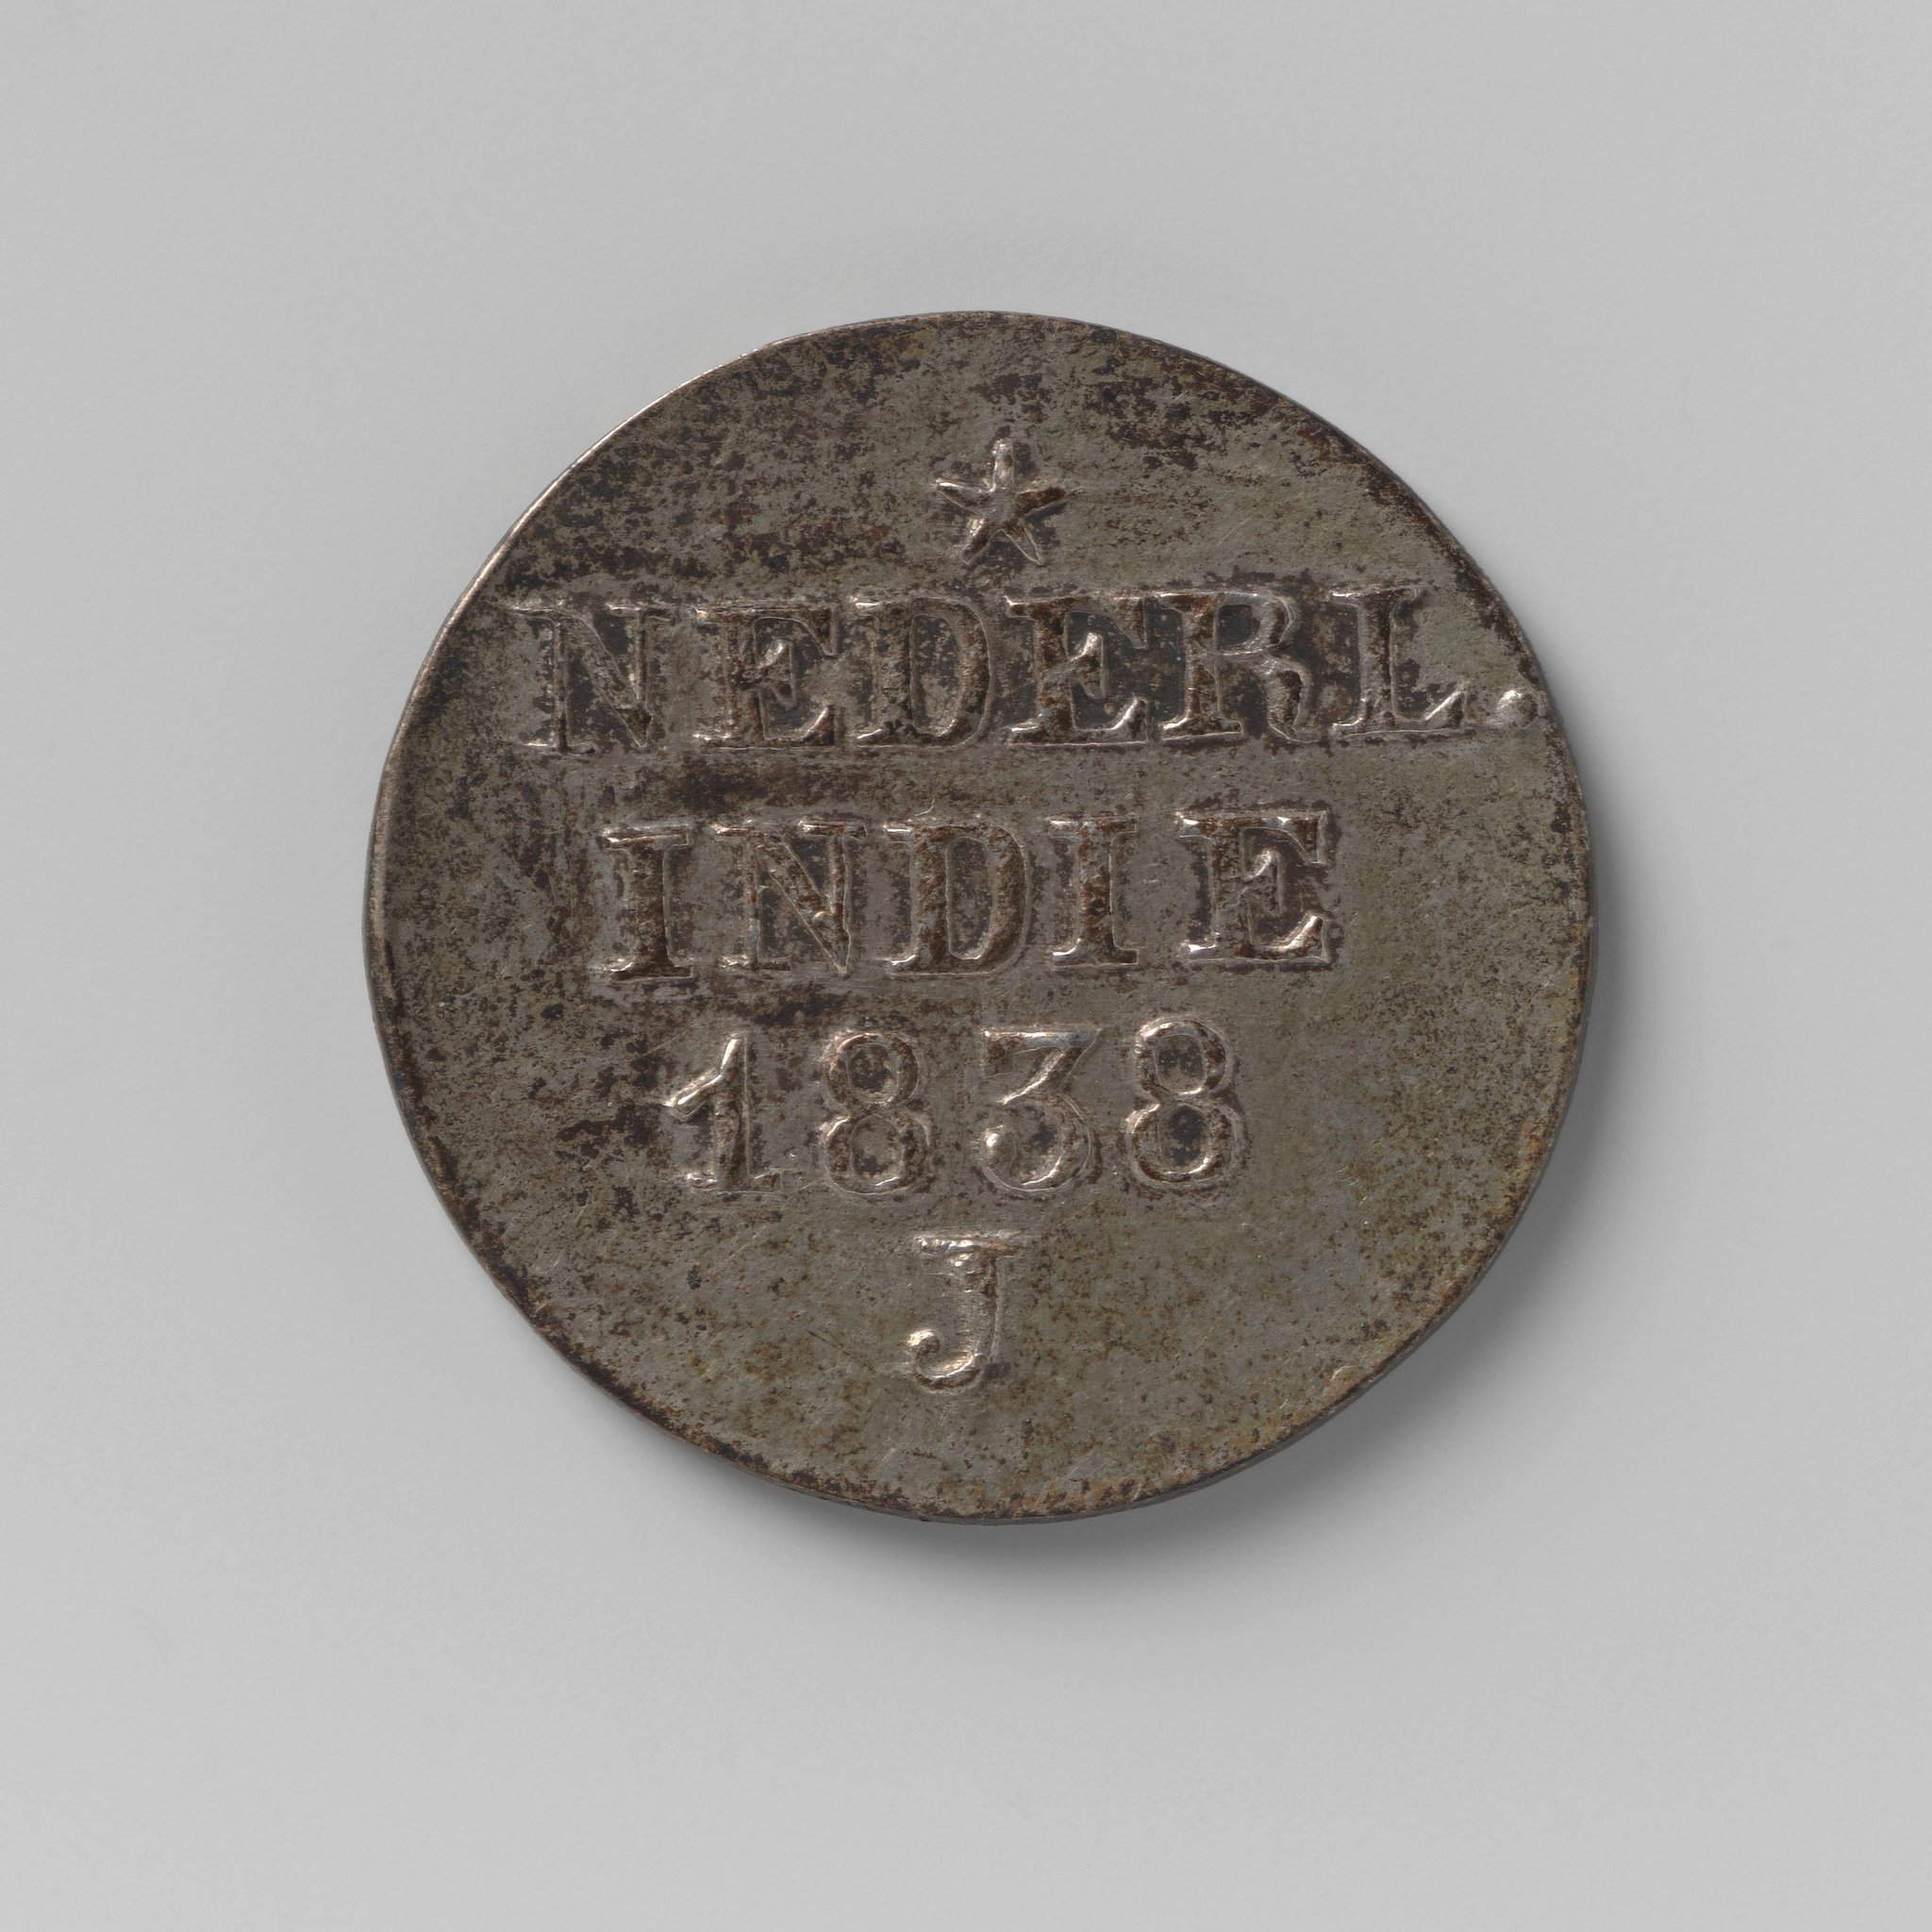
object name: coin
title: Zilveren afslag van een cent van Nederlands Indië,1838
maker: william i of the netherlands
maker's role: koning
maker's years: 1772-1843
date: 1838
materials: silver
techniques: striking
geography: surabaya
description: Zilveren munt. Voorzijde: tussen waarde-aanduiding I CT. gekroond rijkswapenschild. Keerzijde: tweeregelig opschrift, waarboven muntteken en waaronder jaartal. Daaronder letter J [=muntmeester Jeekel]. Gladde rand.